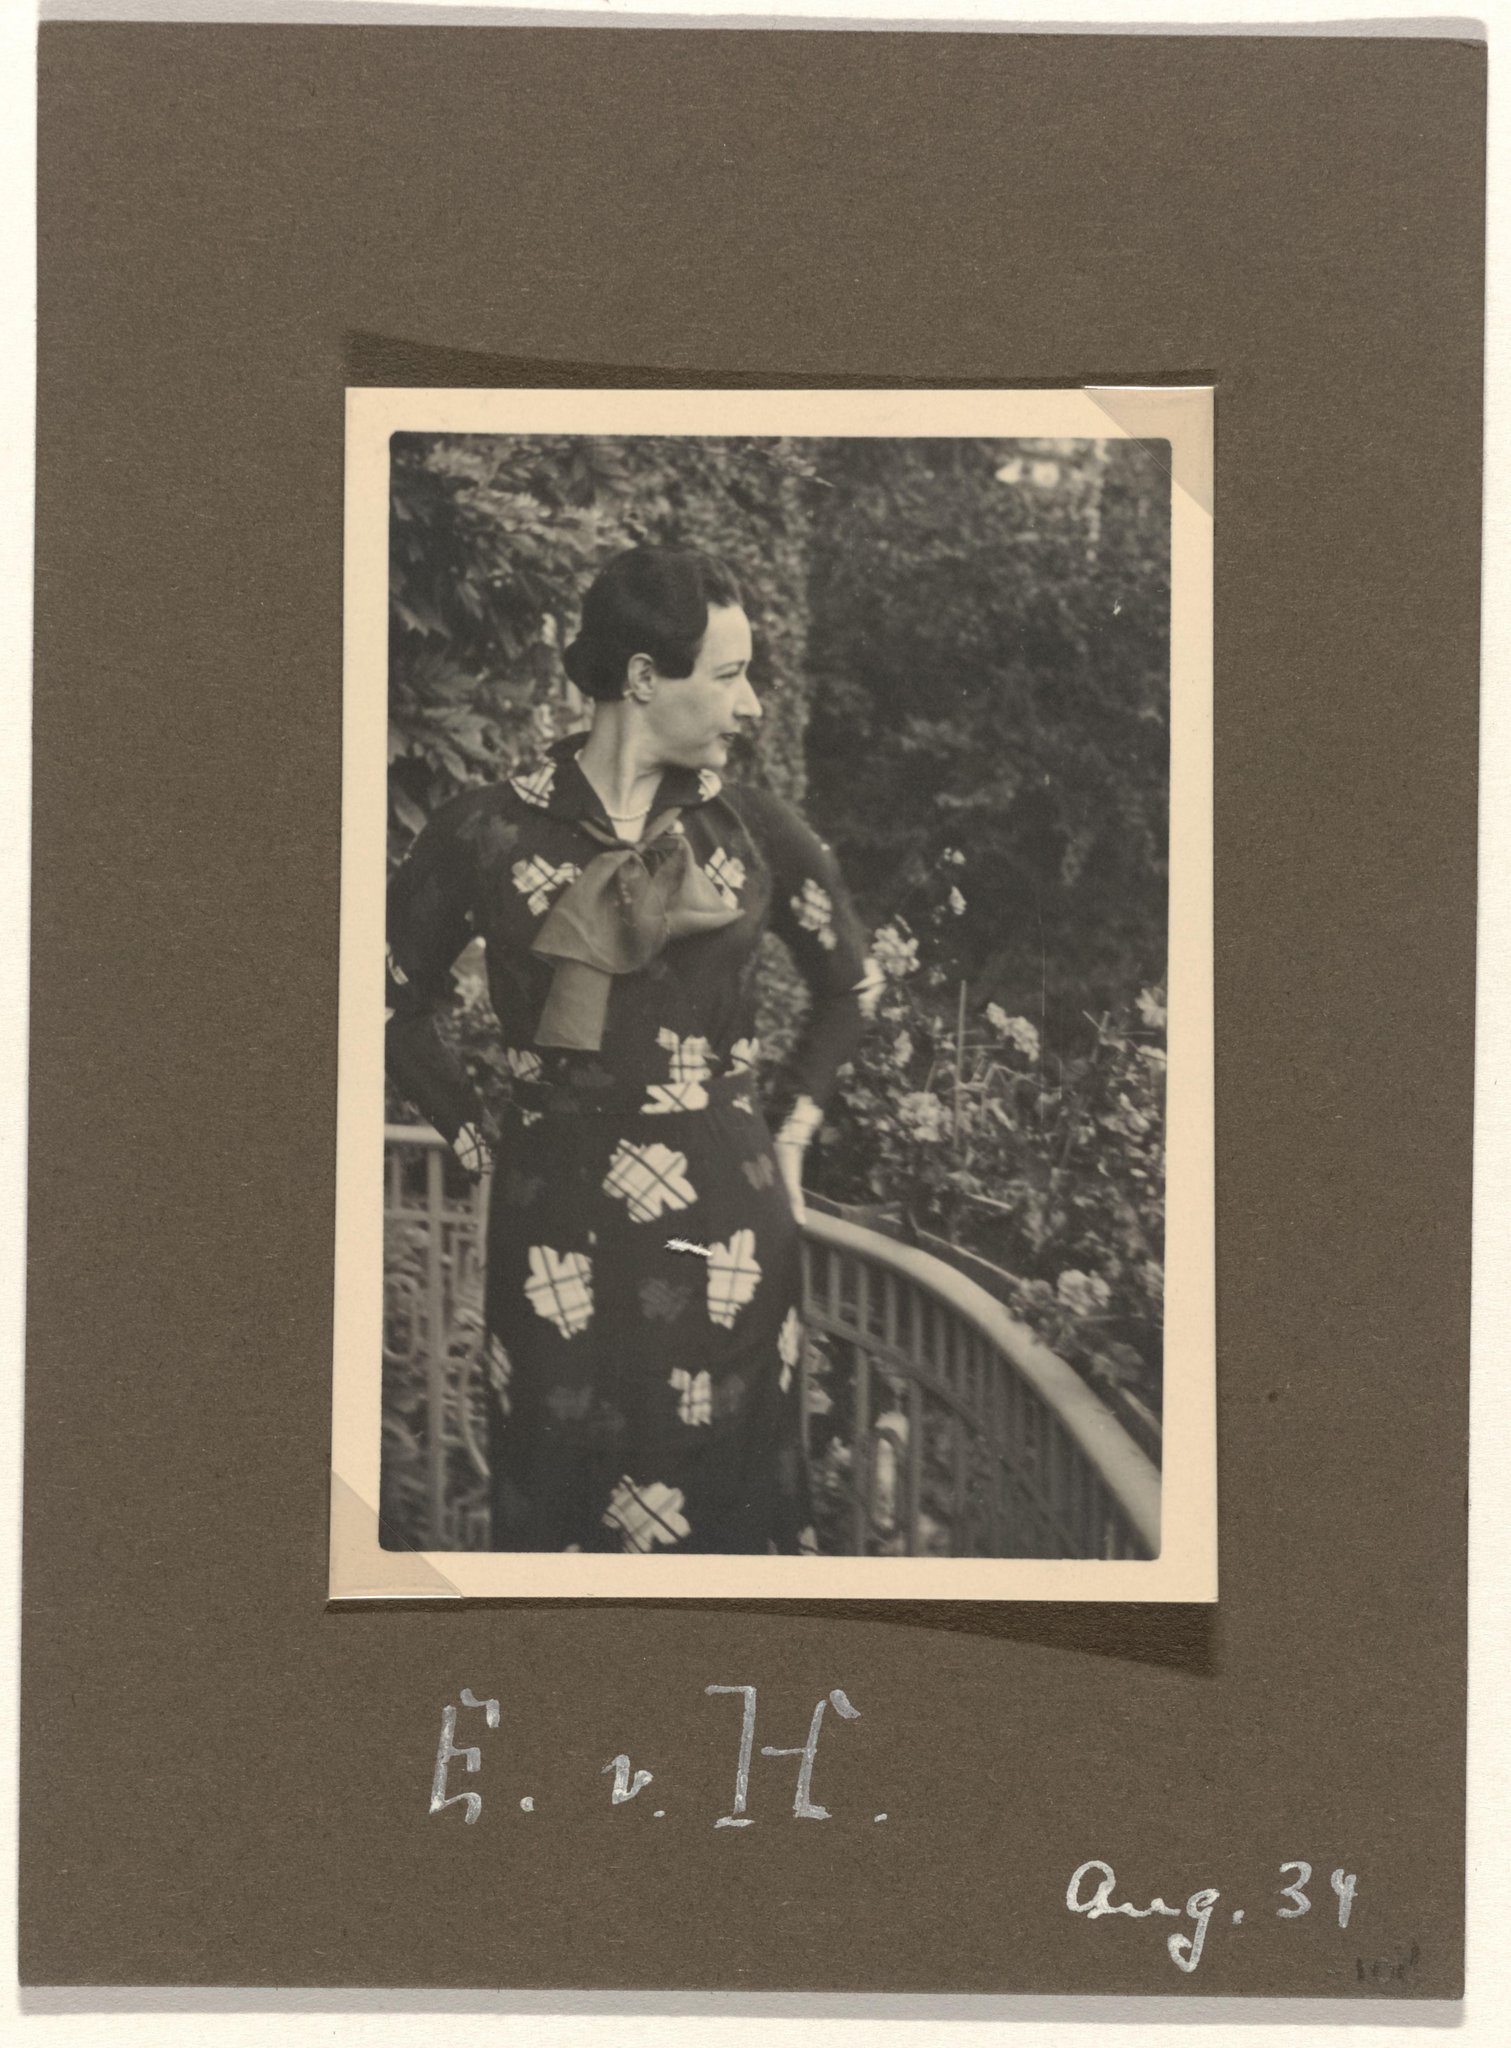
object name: photograph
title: Onbekende vrouw, augustus 1934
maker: Anonymous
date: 1908-1934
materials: photographic support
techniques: gelatin silver print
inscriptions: inscription: ‘E.v.H. Aug.34’